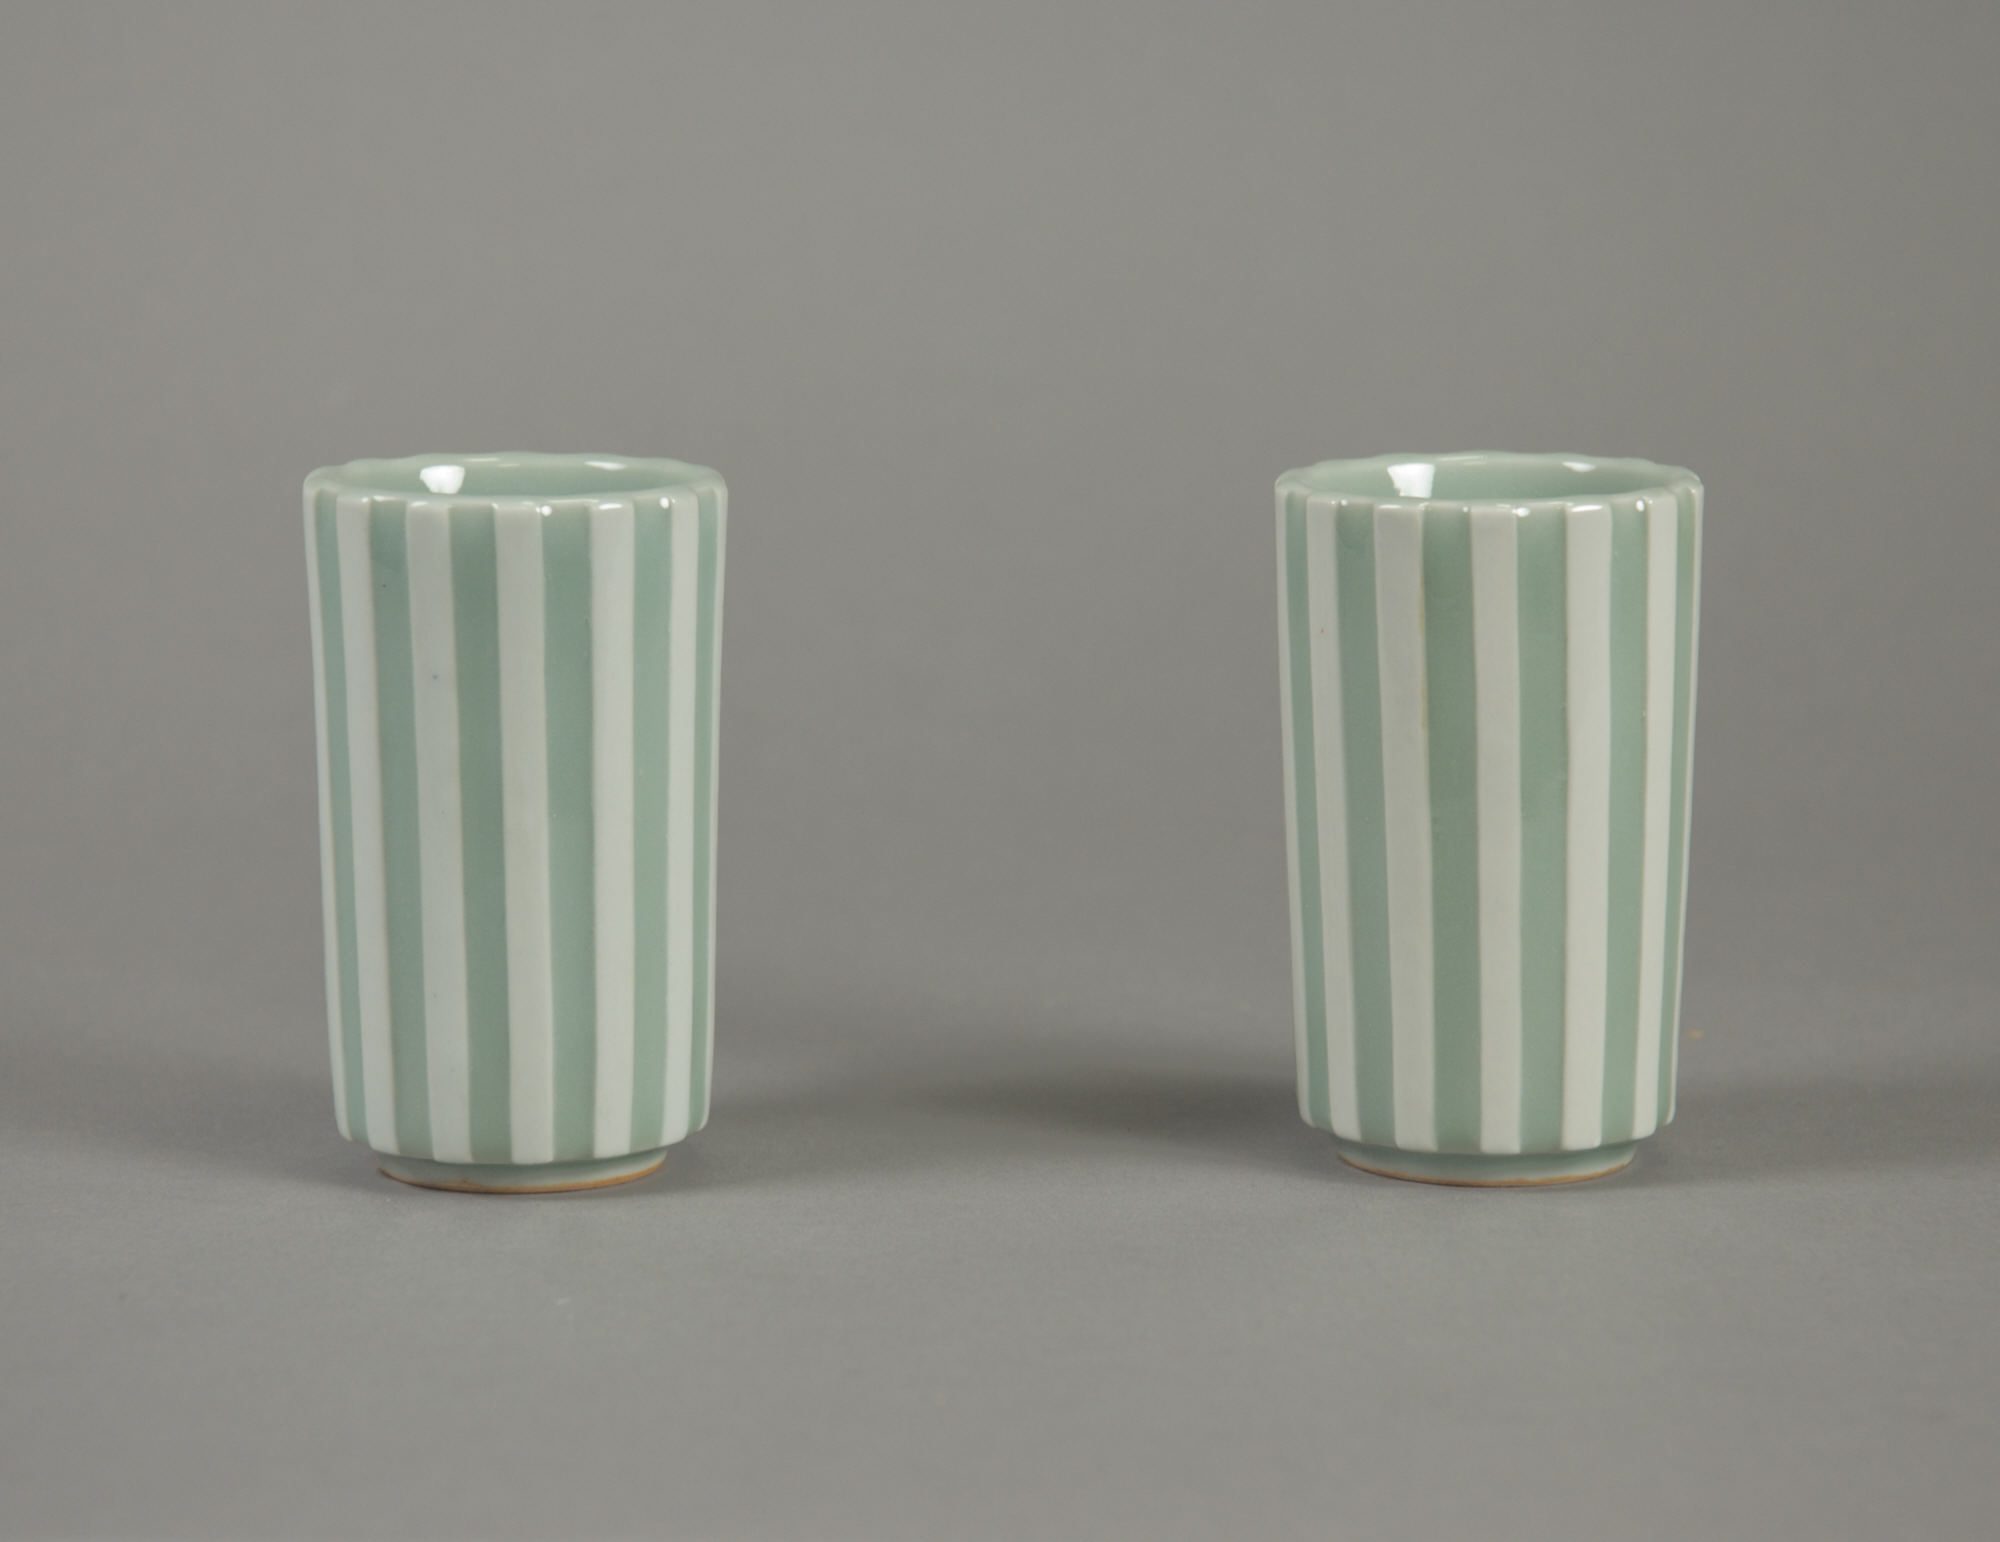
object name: cup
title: Cup with Striped Design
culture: japanese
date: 1701-1800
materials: porcelain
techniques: underglaze